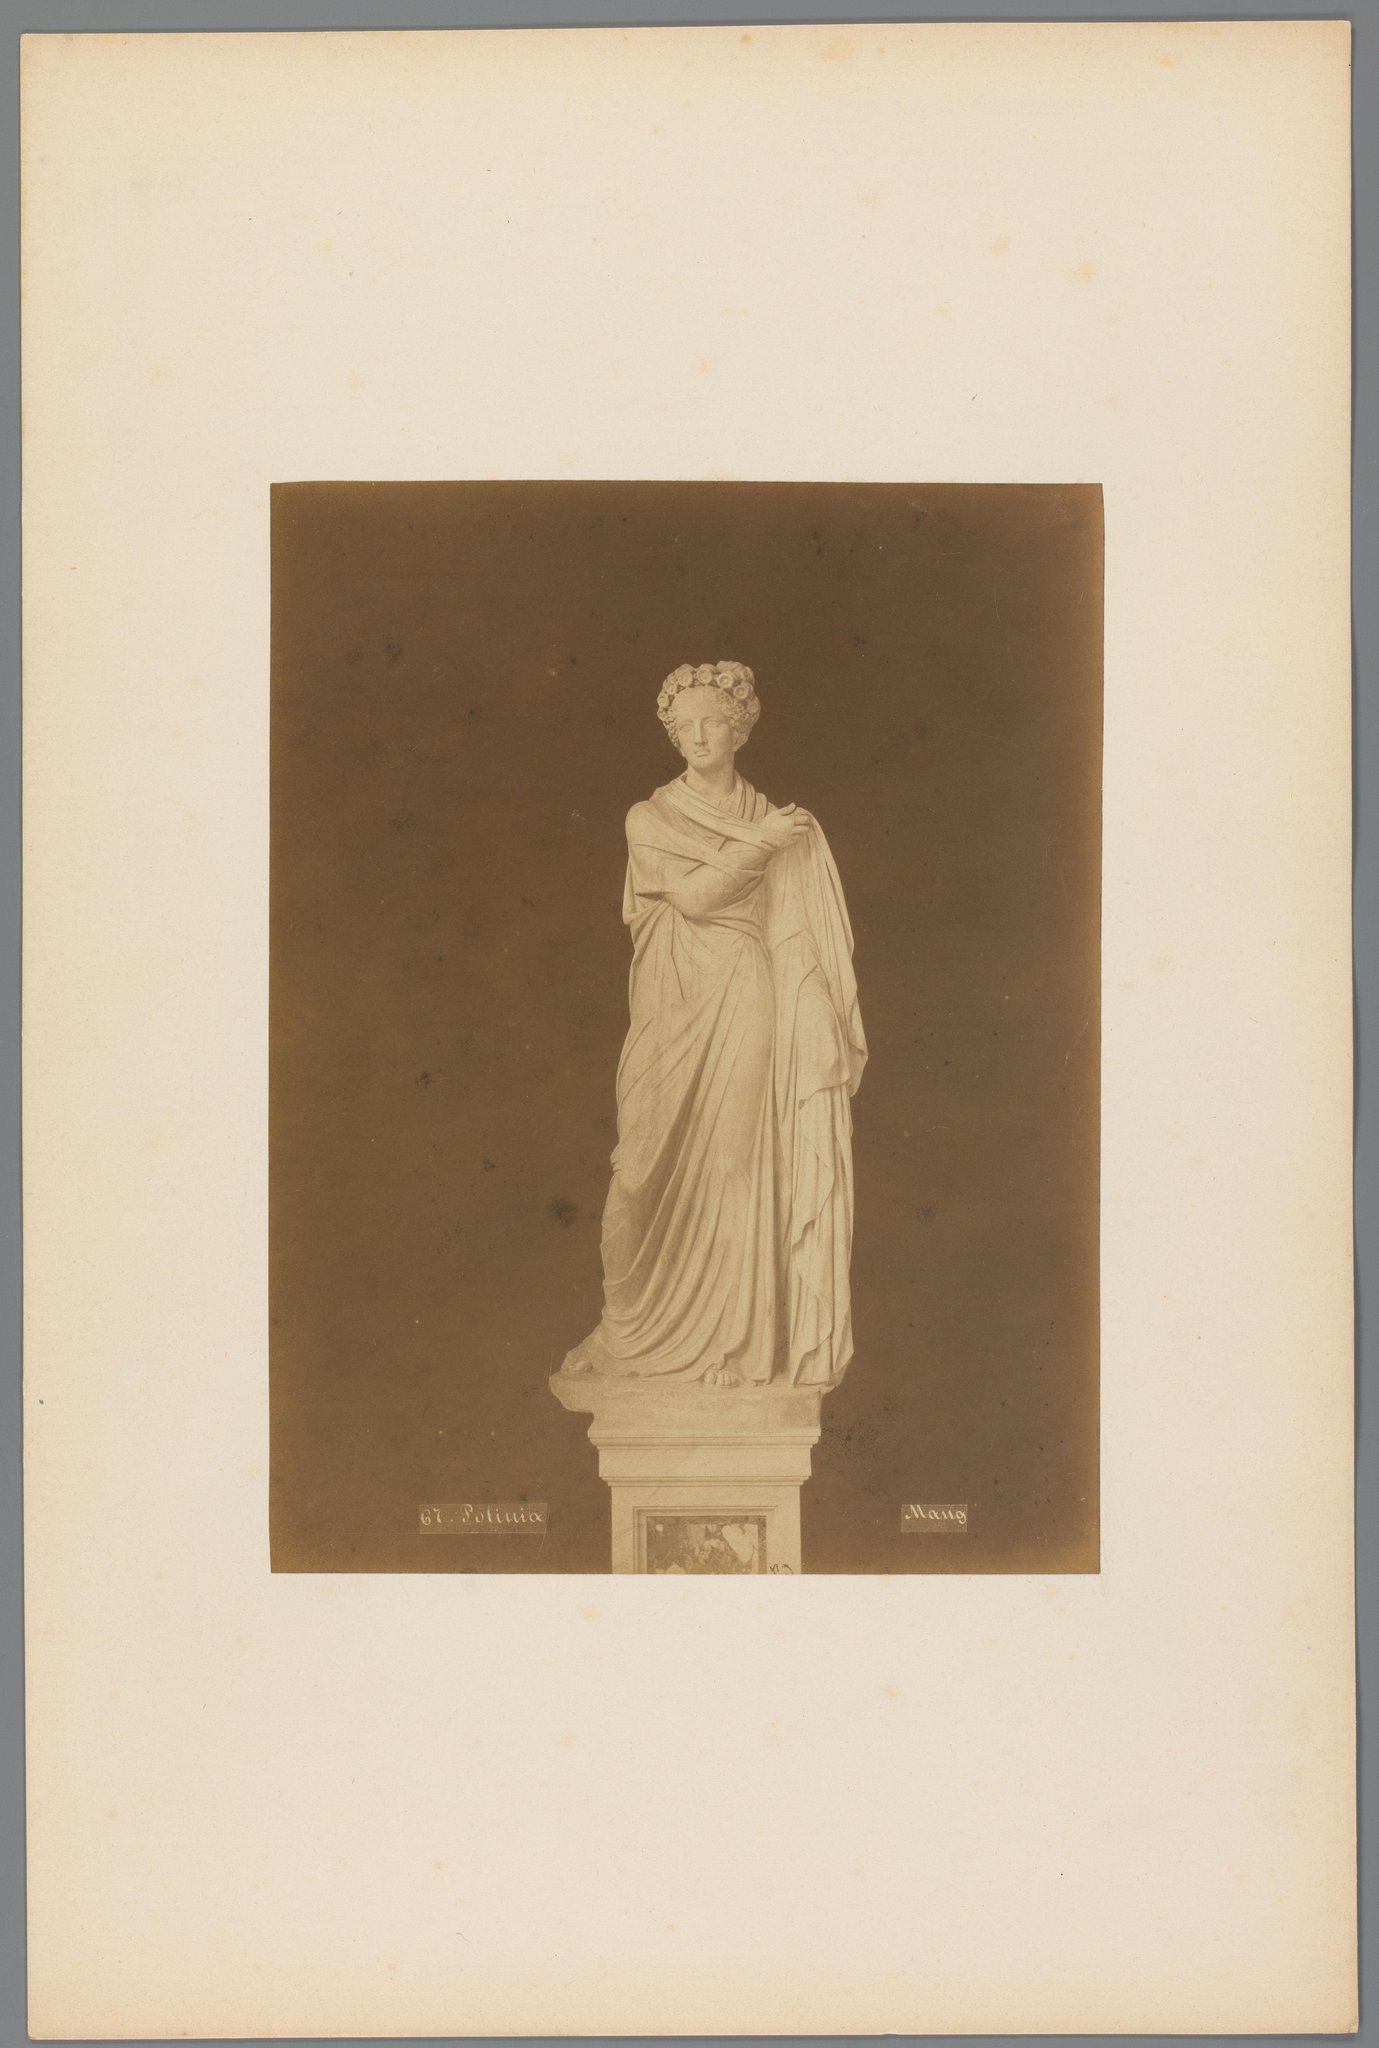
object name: photograph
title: Sculptuur van een vrouw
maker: michèle mang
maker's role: fotograaf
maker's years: 1840-1909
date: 1863-1887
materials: cardboard, paper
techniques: albumen print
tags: piece of sculpture, reproduction of a piece of sculpture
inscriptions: number: ‘67.’